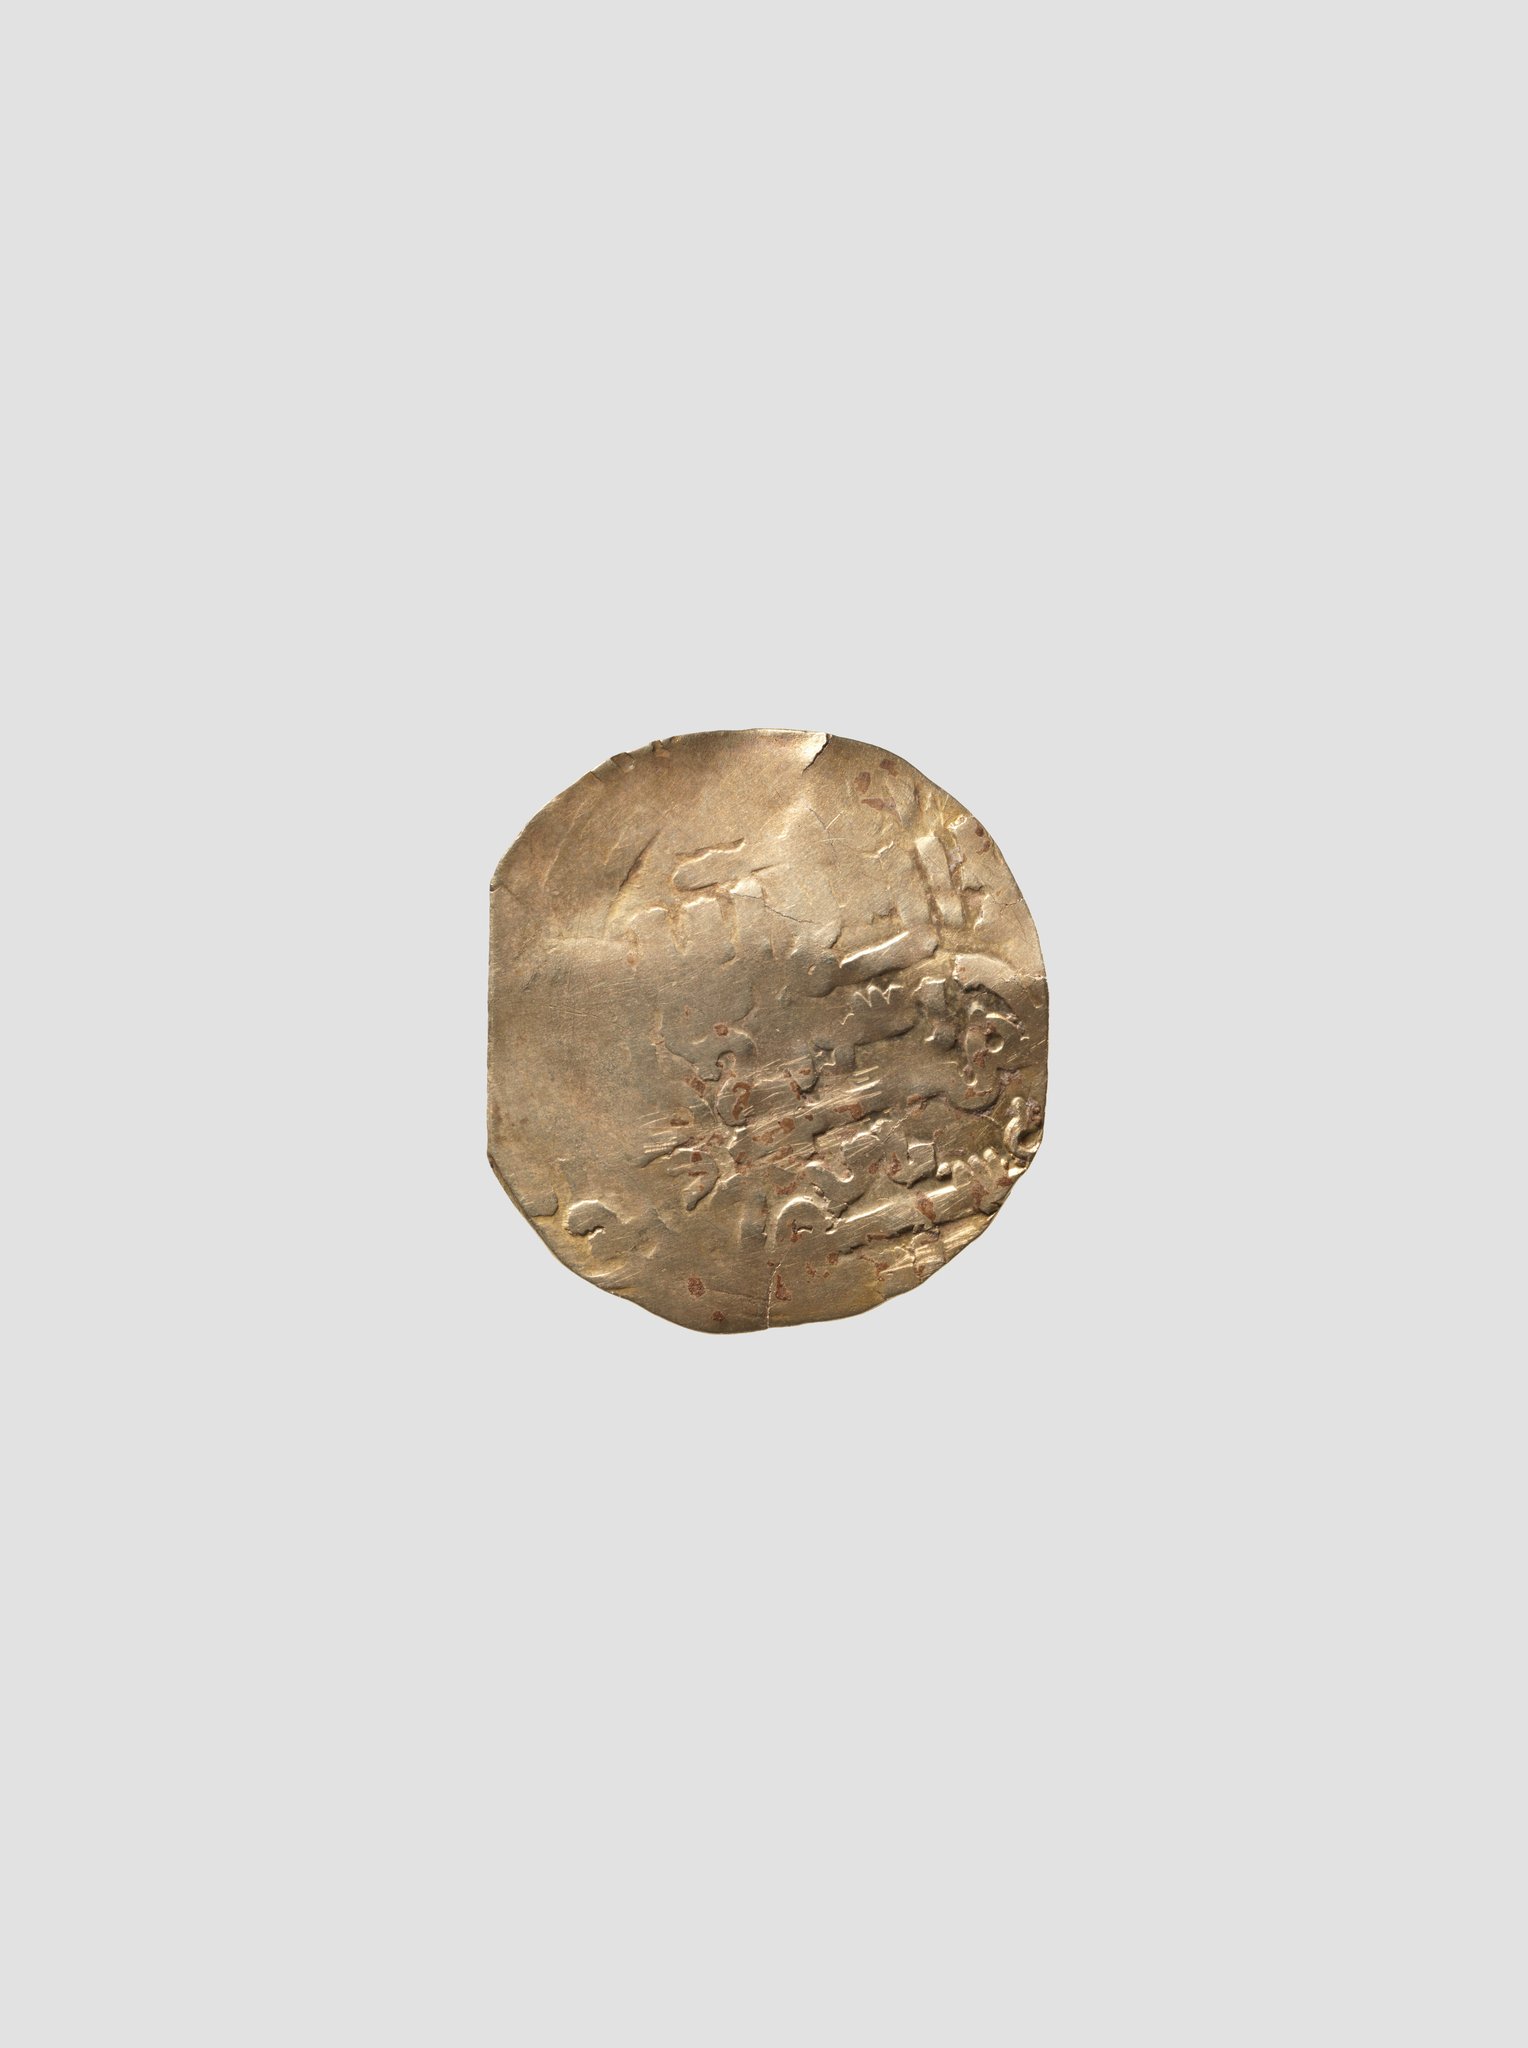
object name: coin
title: Dinar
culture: islamic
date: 1177-1194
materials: gold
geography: iran